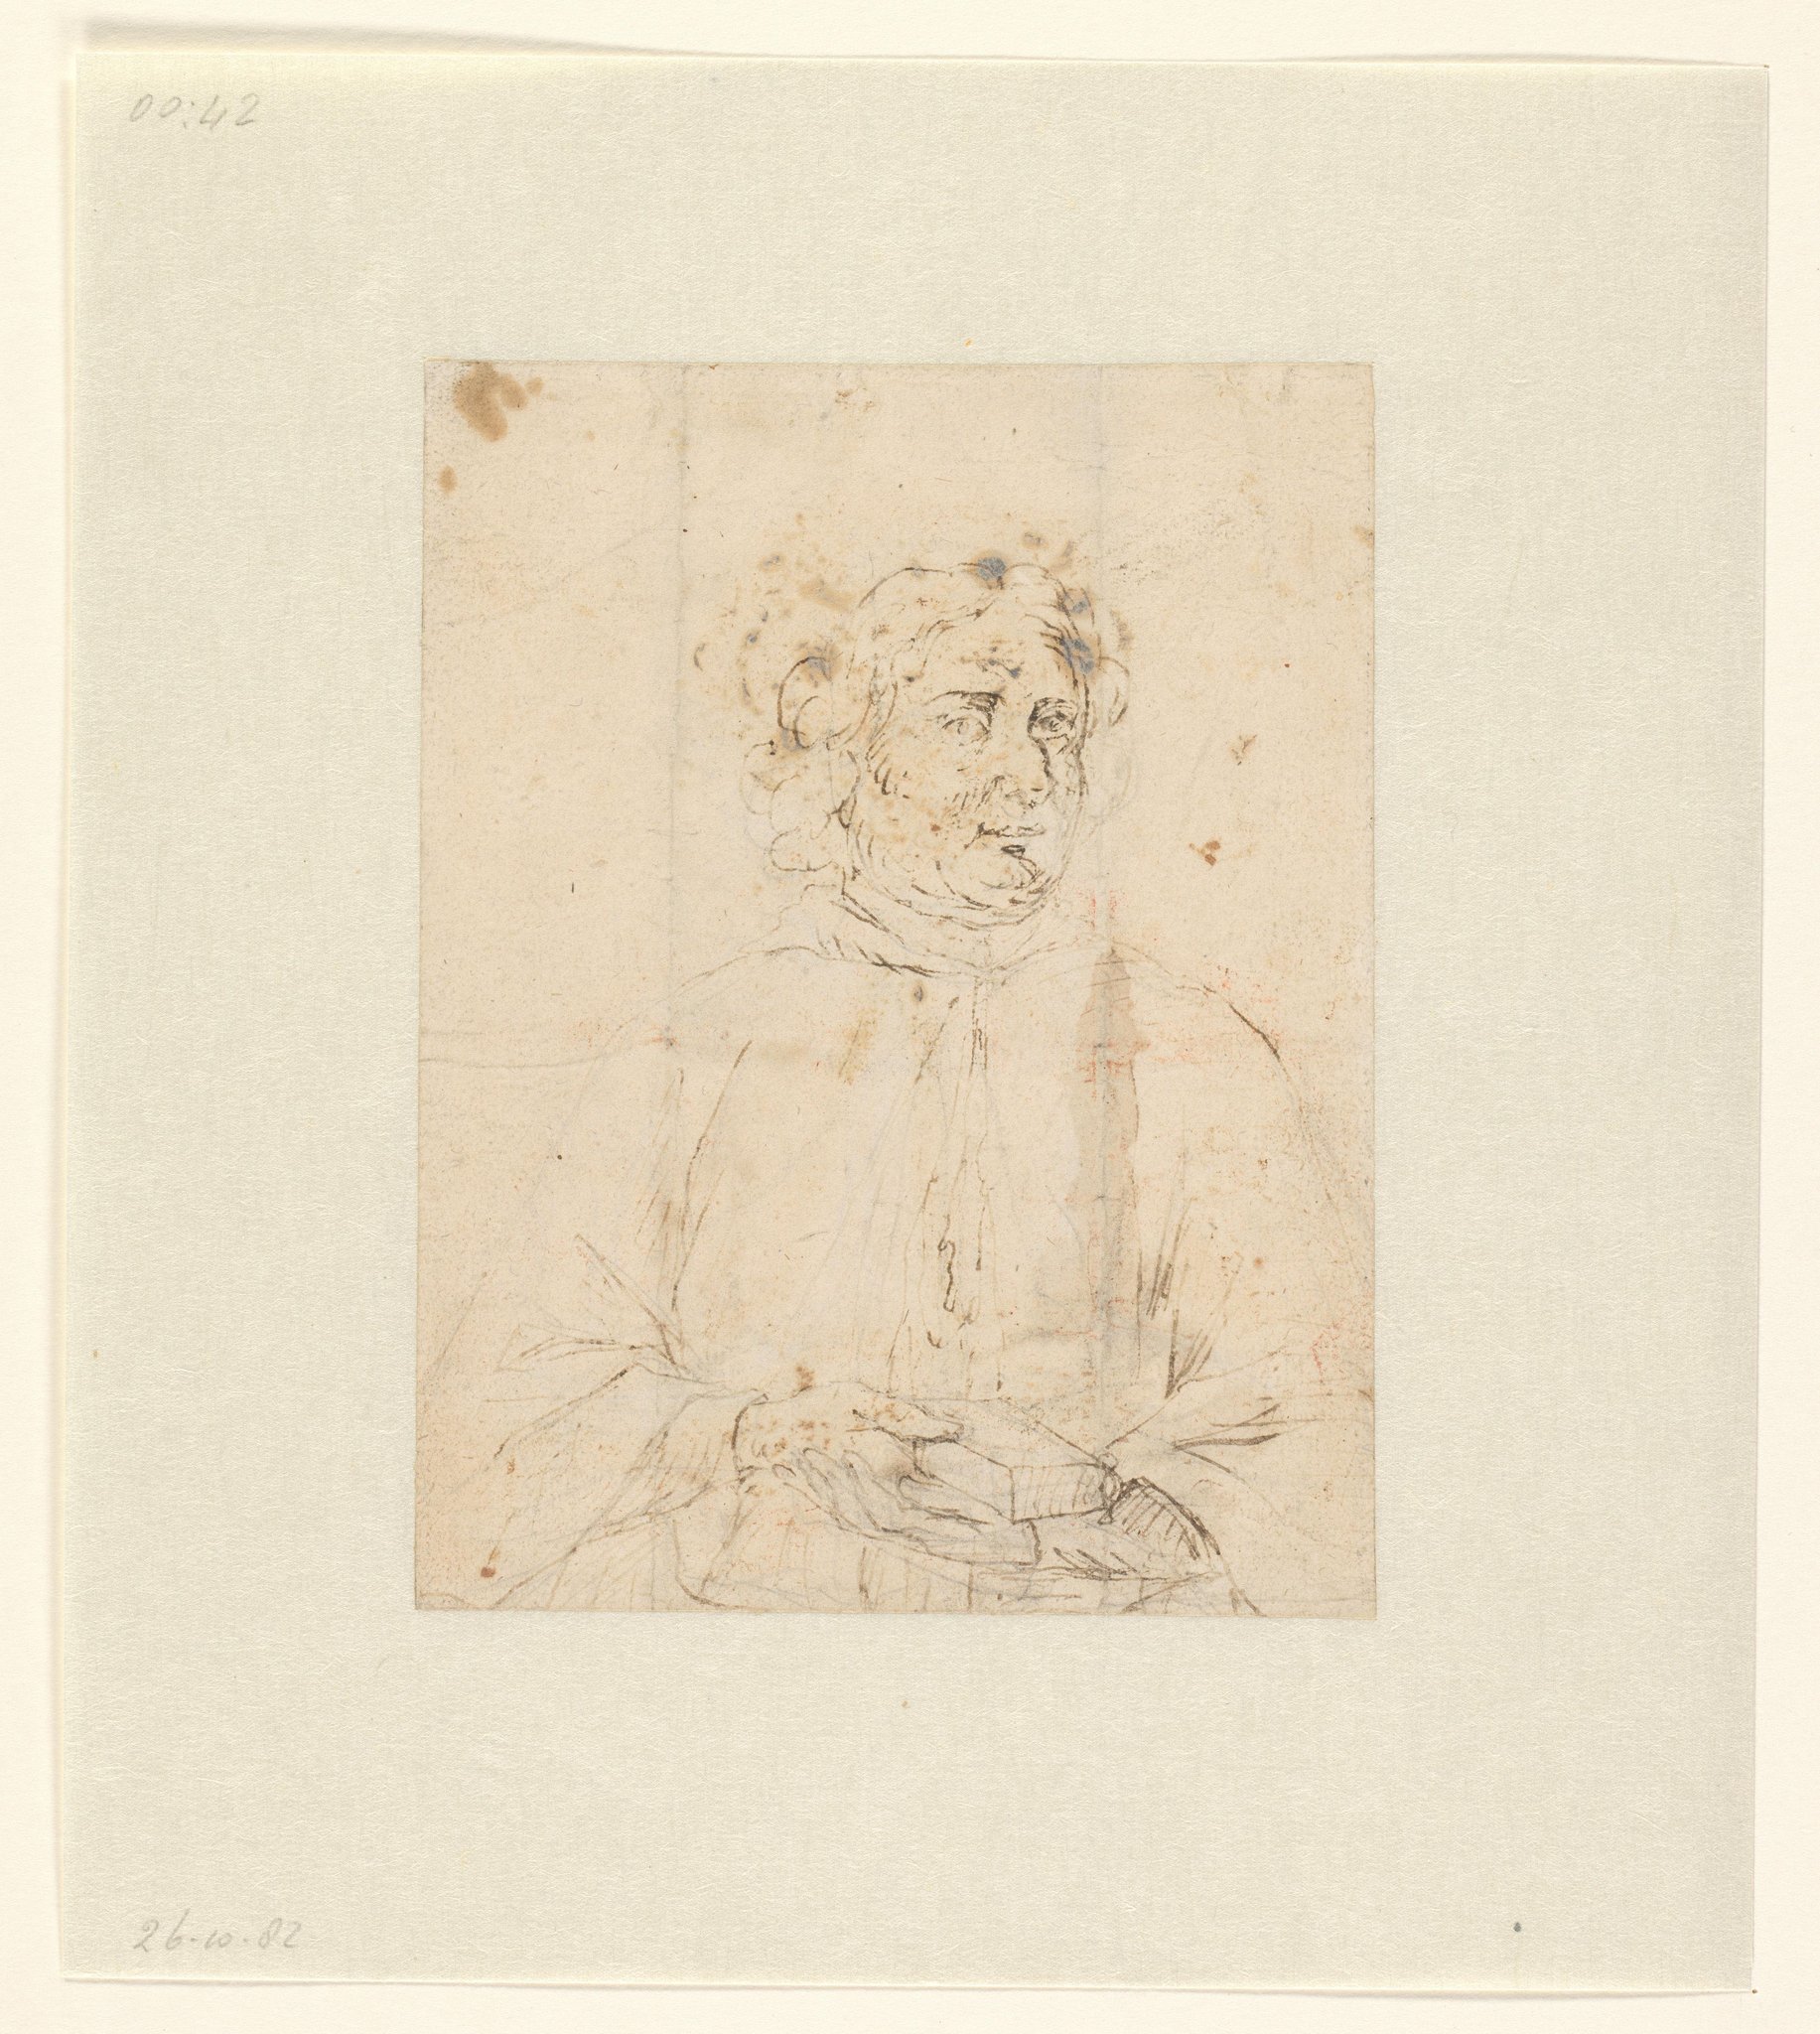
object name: drawing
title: Portret van een man met een boek in zijn handen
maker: matthys van den bergh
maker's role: draughtsman, print maker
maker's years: 1617-1687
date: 1627-1687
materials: ink, paper, pencil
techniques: pen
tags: historical persons not known by name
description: Portret van een man ten halven lijve, iets naar rechts.